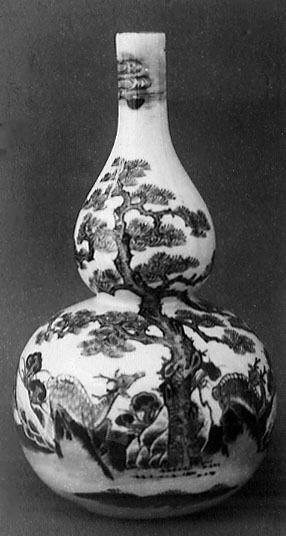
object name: bottle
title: Gourd-Shaped Bottle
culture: japanese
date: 1701-1800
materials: glaze, porcelain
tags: trees